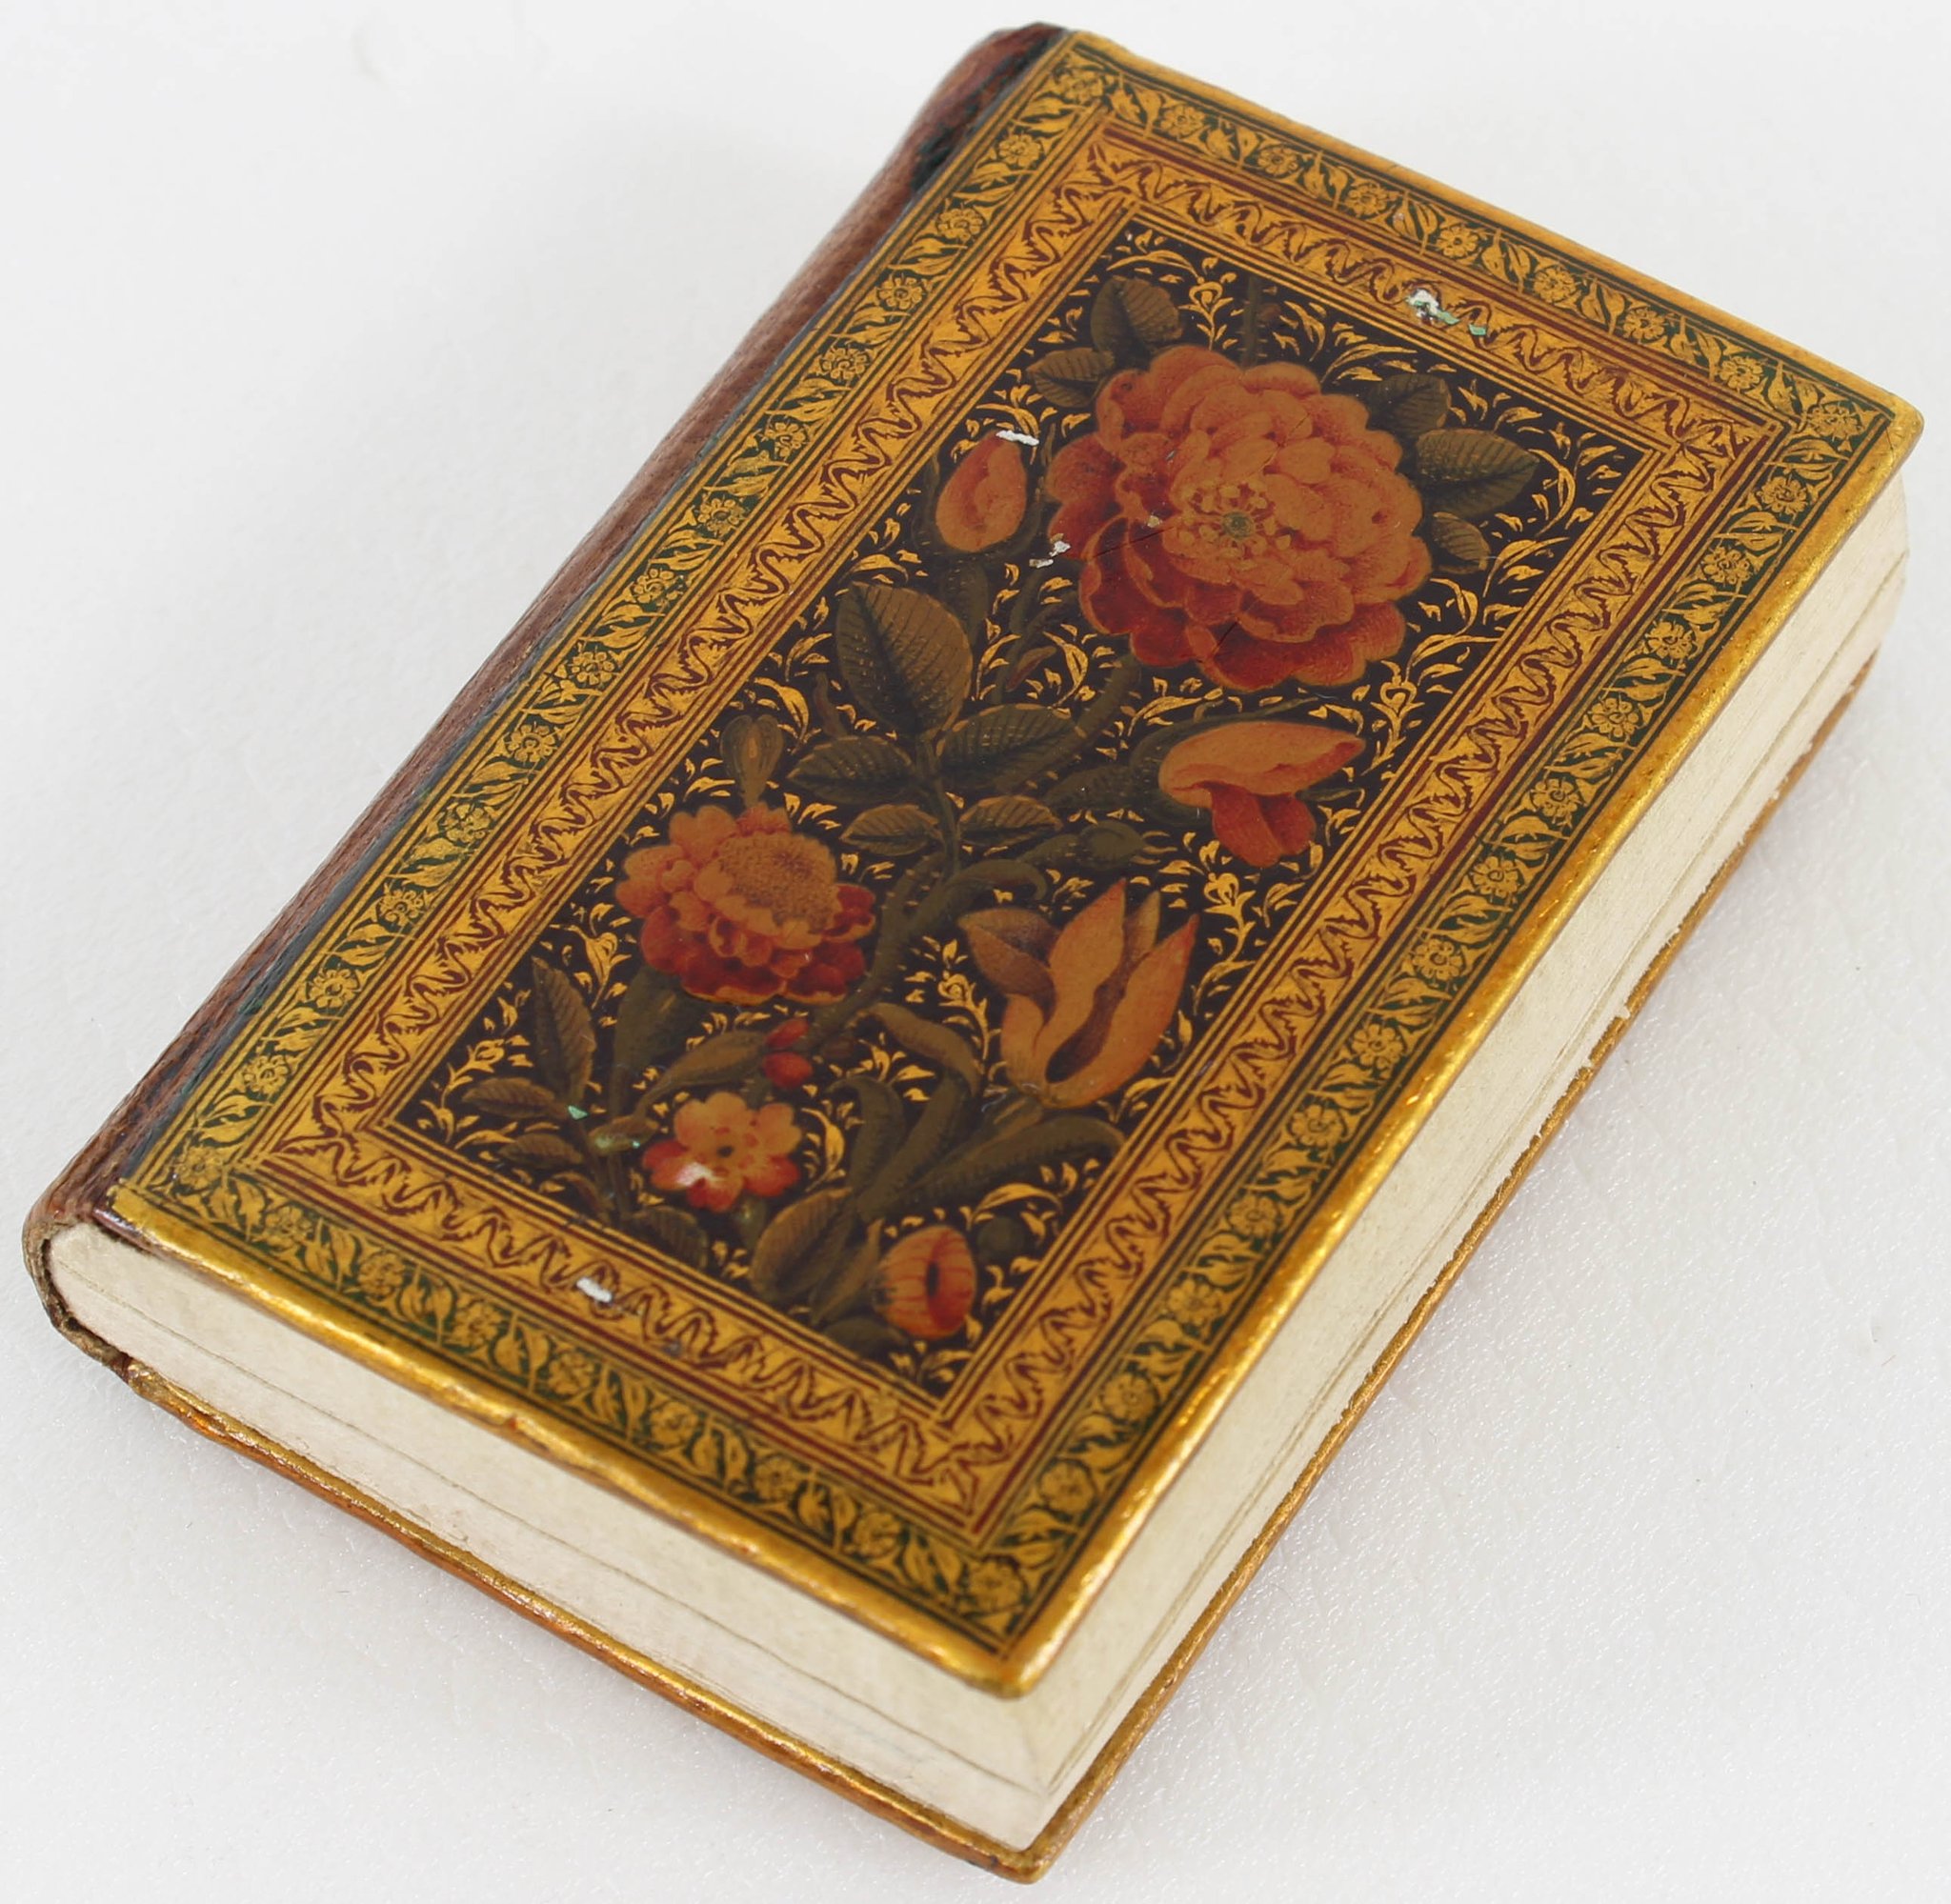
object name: non illustrated manuscript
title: Miniature Qur'an with Lacquered Binding and Carrying Case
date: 1801-1900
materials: gold, ink, paper, parchment, silver, watercolor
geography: iran